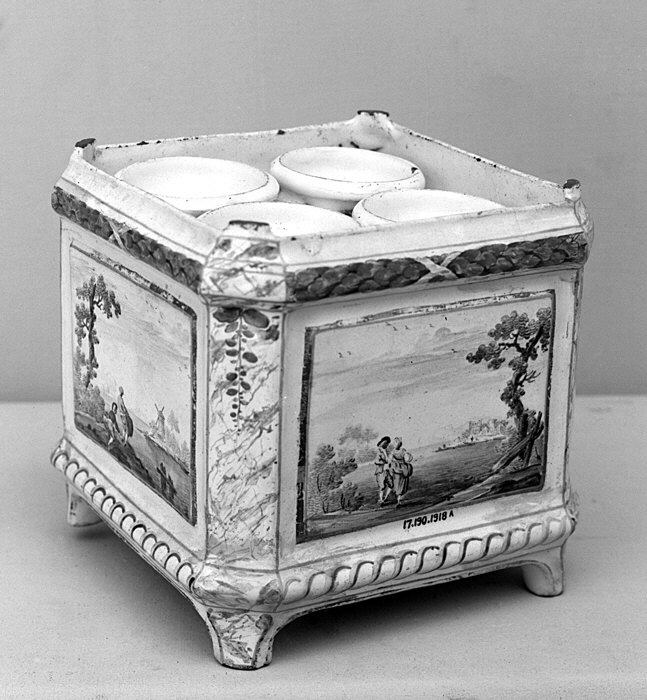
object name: jardinière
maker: fidelle duvivier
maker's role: decorator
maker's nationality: french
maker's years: 1740-1796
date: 1753-1795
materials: faience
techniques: glazing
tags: human figures,trees,boats